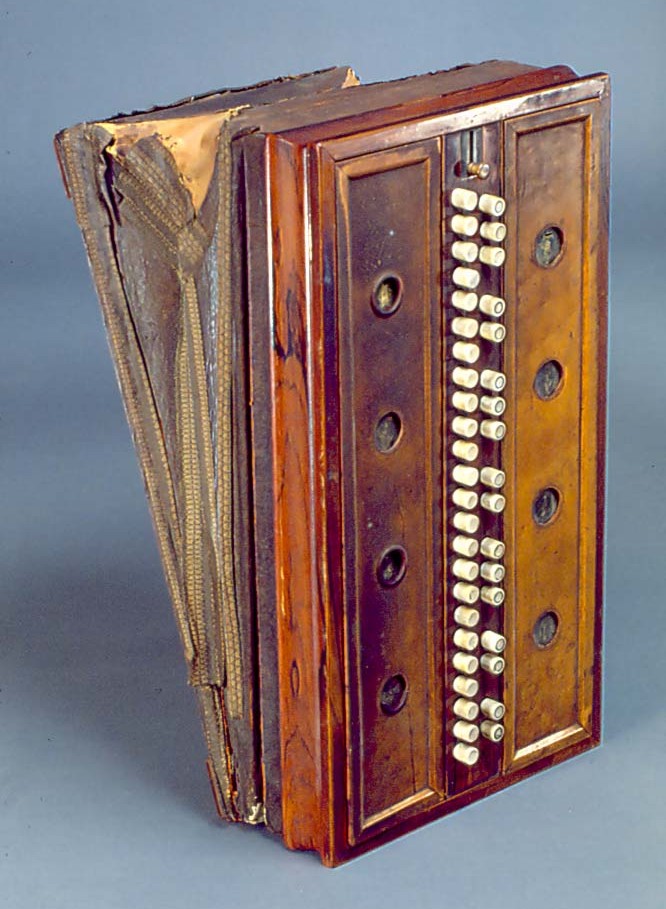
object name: rocking melodeon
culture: american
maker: abraham prescott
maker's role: maker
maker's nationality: american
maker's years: 1789-1858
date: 1825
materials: wood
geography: united states